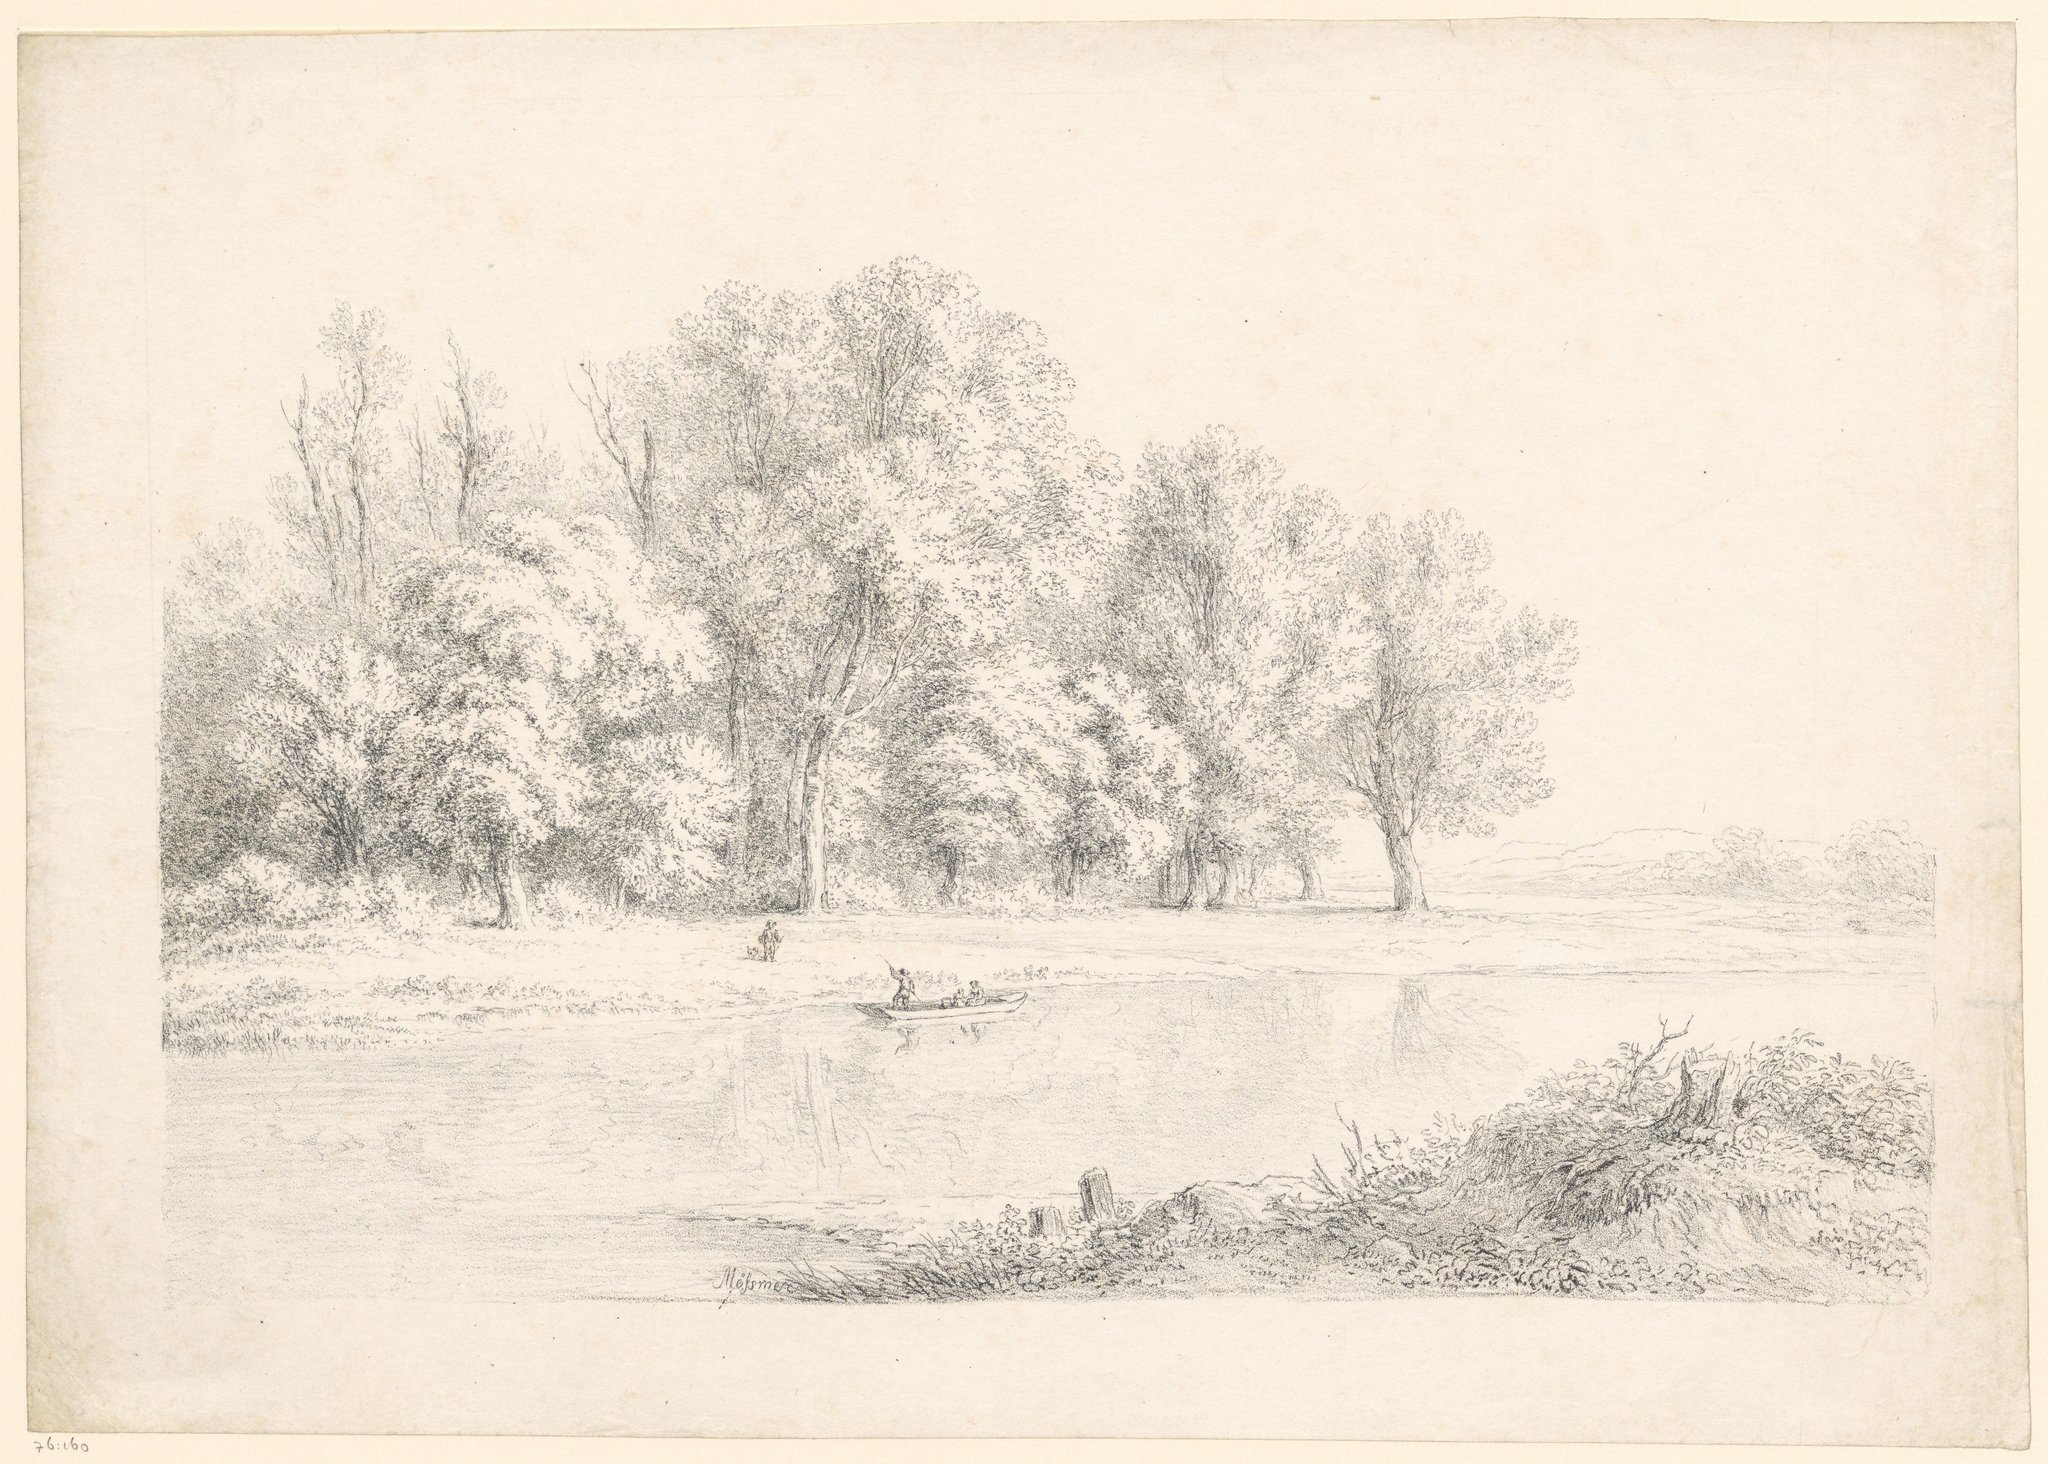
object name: print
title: Landschappen door Joseph Mössmer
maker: joseph mössmer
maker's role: print maker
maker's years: 1780-1845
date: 1818-1821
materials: paper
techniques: lithograph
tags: water course, rowing-boat, canoe, etc., landscapes in the temperate zone (+ landscape with figures, staffage)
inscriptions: collector's mark: Lugt 2228, collector's mark: Lugt 2760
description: Deze prent behoort waarschijnlijk tot een serie met zeventien landschappen door Joseph Mössmer uit ca. 1818-1821. Mogelijk is dit de derde prent in de serie.